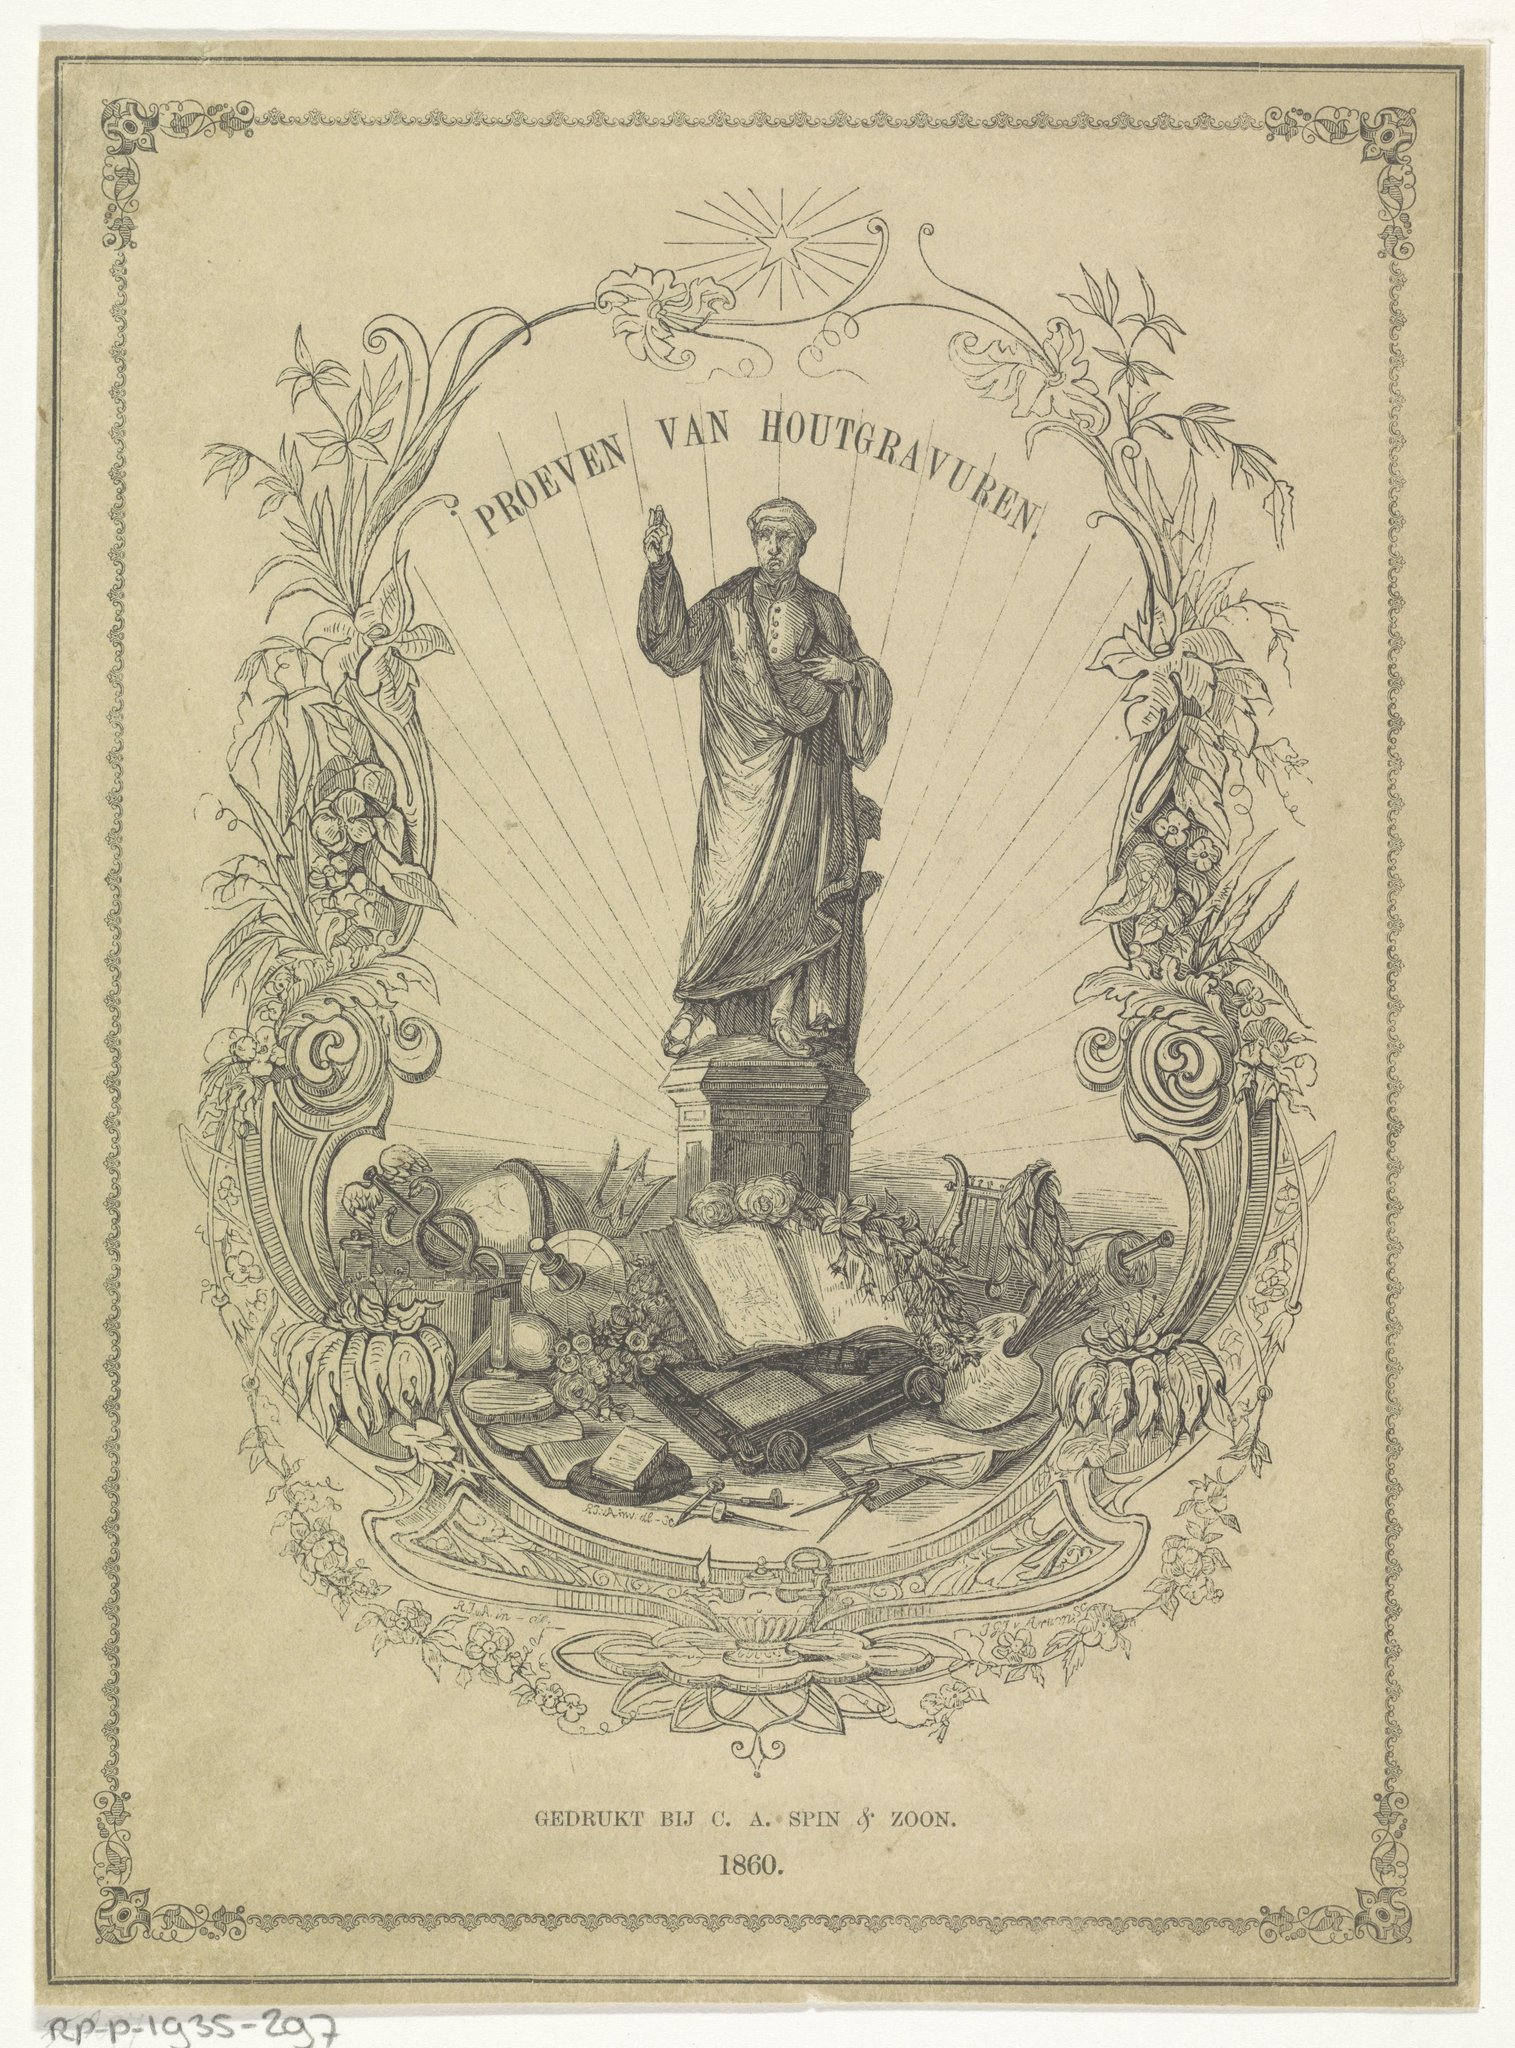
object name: print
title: Proeven van houtgravuren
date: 1860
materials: paper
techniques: engraving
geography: amsterdam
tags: honouring the artist with laurel wreath, compasses, harp, monument, statue, globe, square (drawing-instrument)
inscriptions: collector's mark: Lugt 2760, collector's mark: Lugt 2228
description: Standbeeld van Laurens Jansz. Coster. Rondom ligt een aantal allegorische objecten, waaronder een wereldbol, een harp, een lauwerkrans, een passer en een winkelhaak. Geheel in een geornamenteerde ovale omlijsting met bloemen en planten.